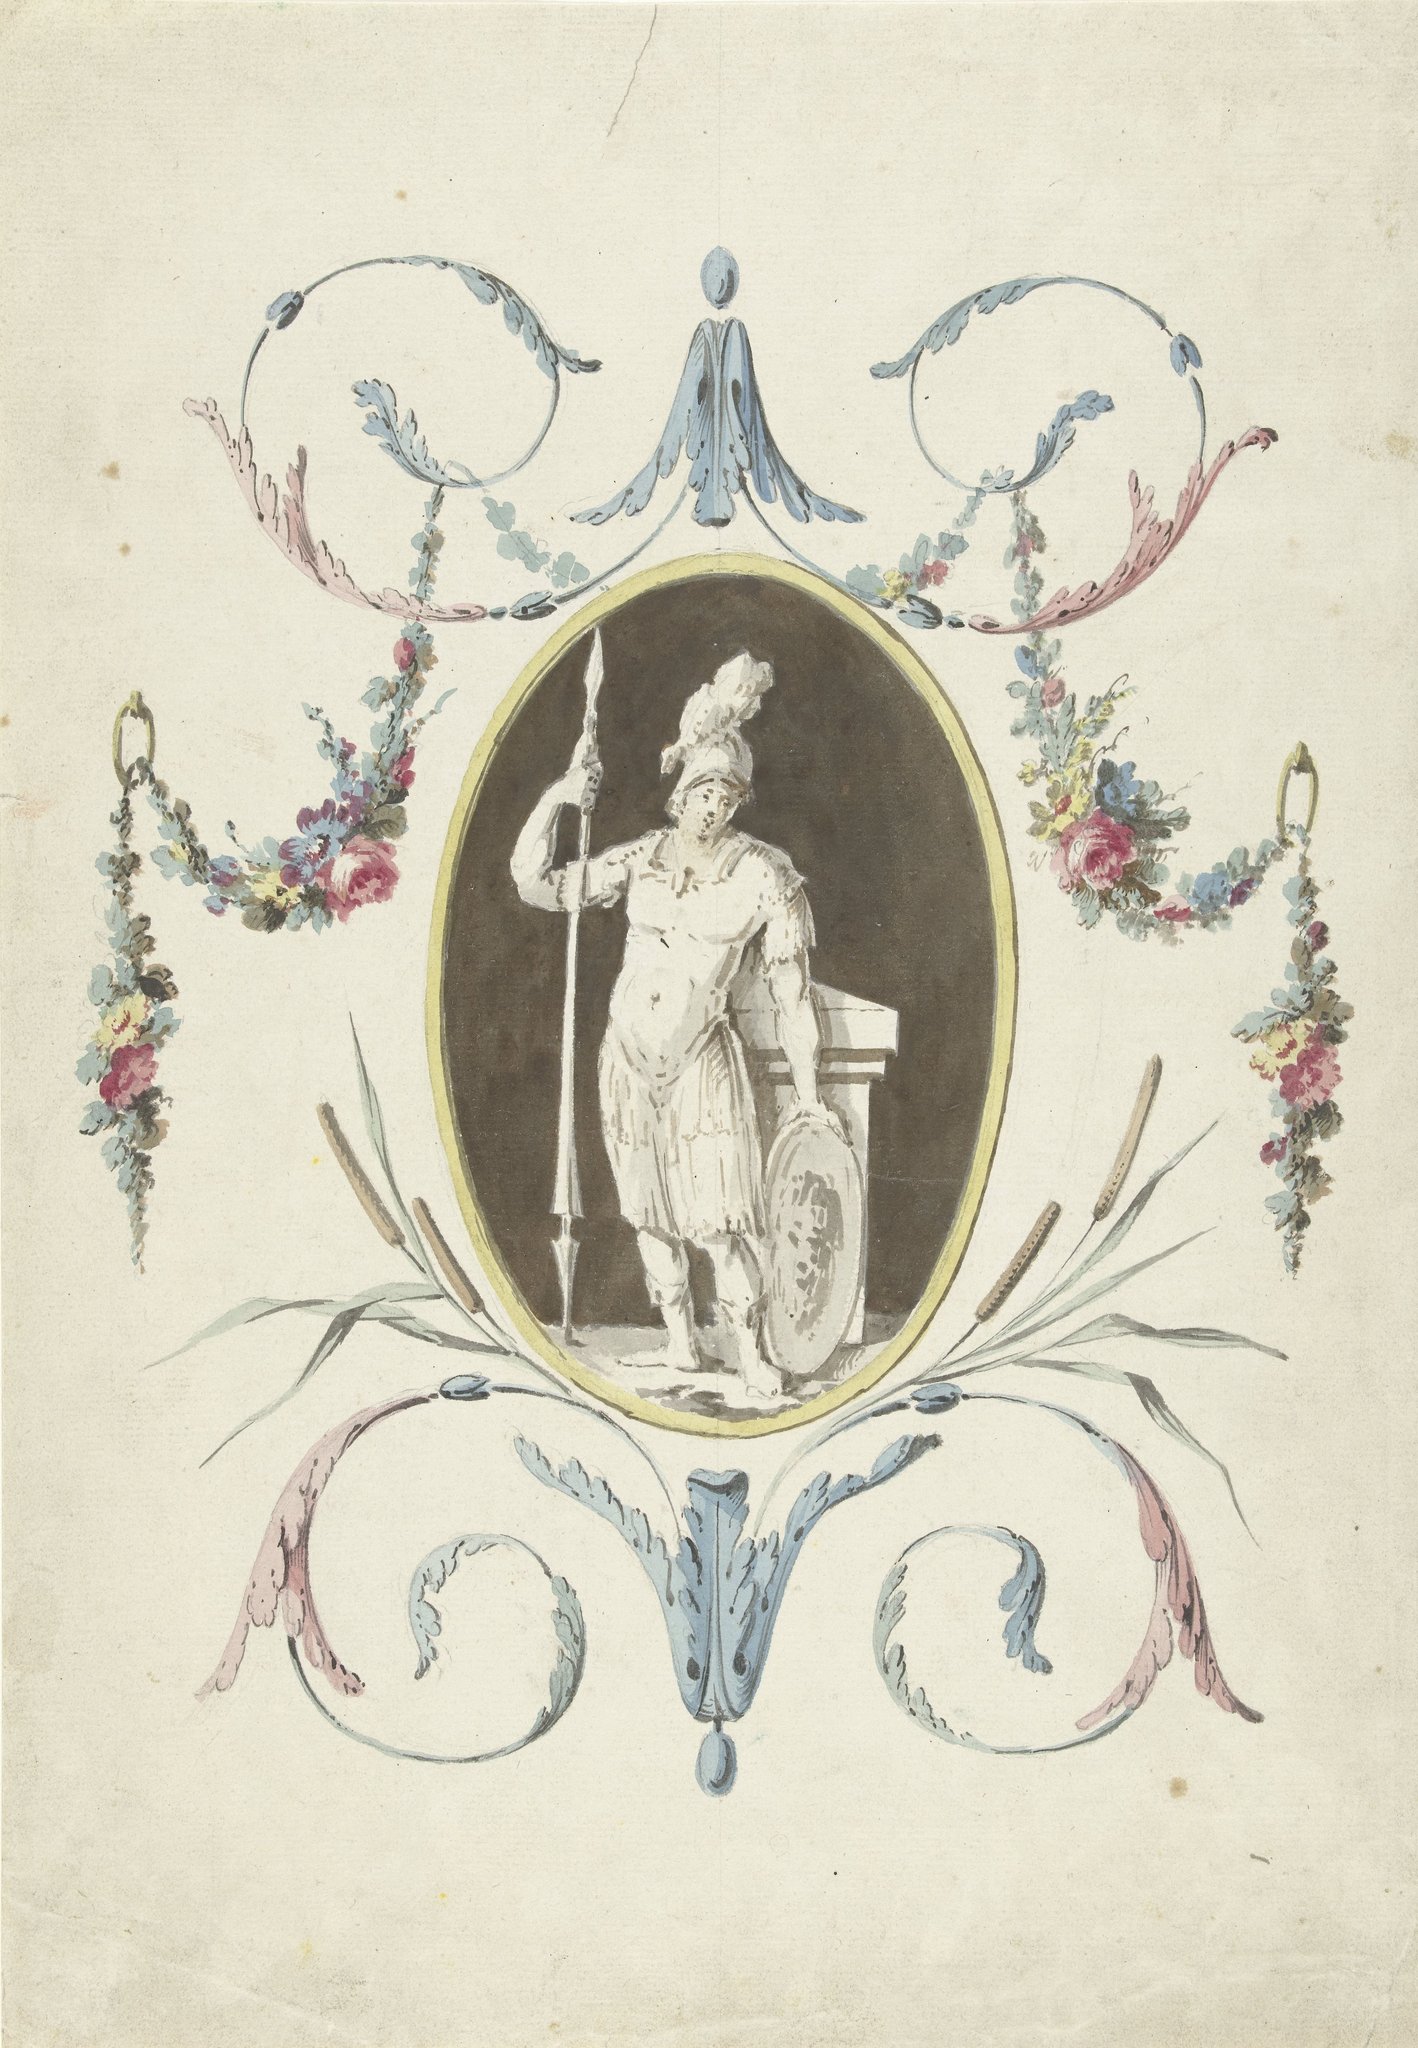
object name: design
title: Ontwerp voor kamerversiering met een paneel met een staande krijger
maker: abraham meertens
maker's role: draughtsman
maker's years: 1757-1823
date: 1767-1823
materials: ink, paper, pencil, watercolor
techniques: brush, pen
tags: wall-covering